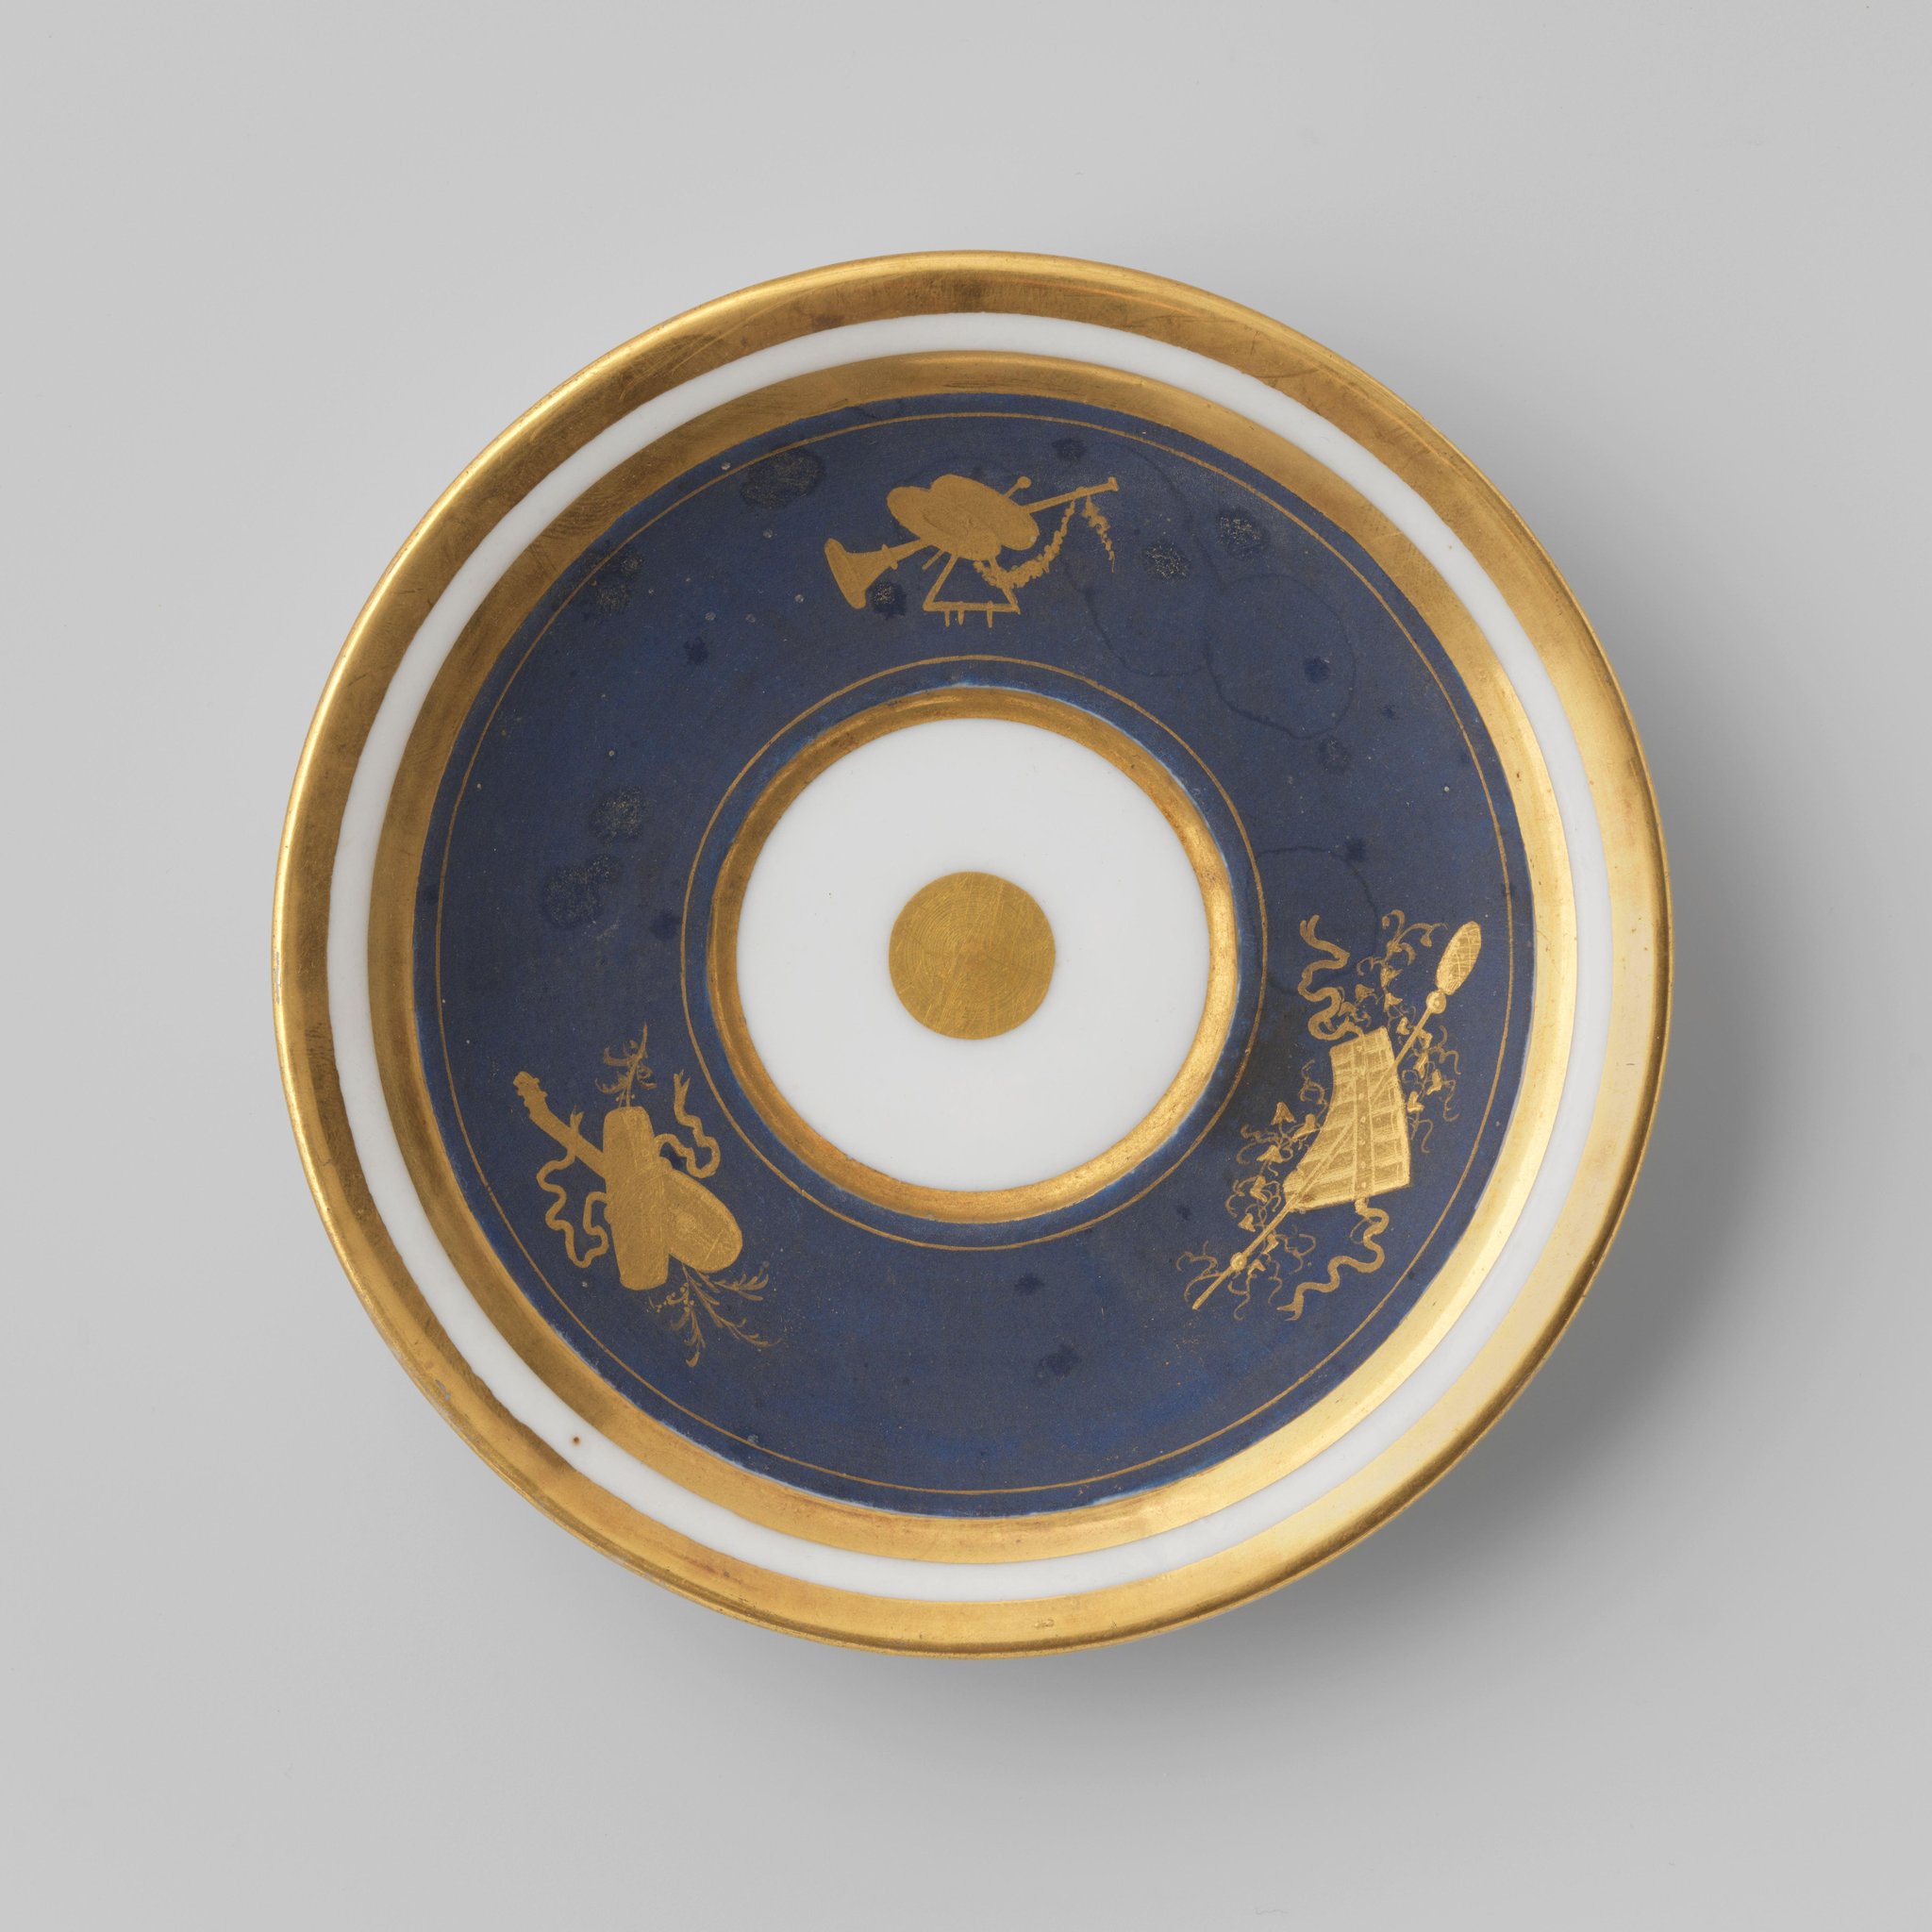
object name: platter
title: Saucer with musical instruments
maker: Anonymous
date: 1800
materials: glaze, gold, paint, porcelain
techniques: firing, forming, gilding, relief, turning, vitrification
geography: france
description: Schotel van porselein op hoge voetring, beschilderd in blauw en goud. In het centrum een medaillon en op de wand een band met goud, waarover blauw is aangebracht. Hierin gegrift driemaal een muziekinstrument. Gouden banden op de rand.